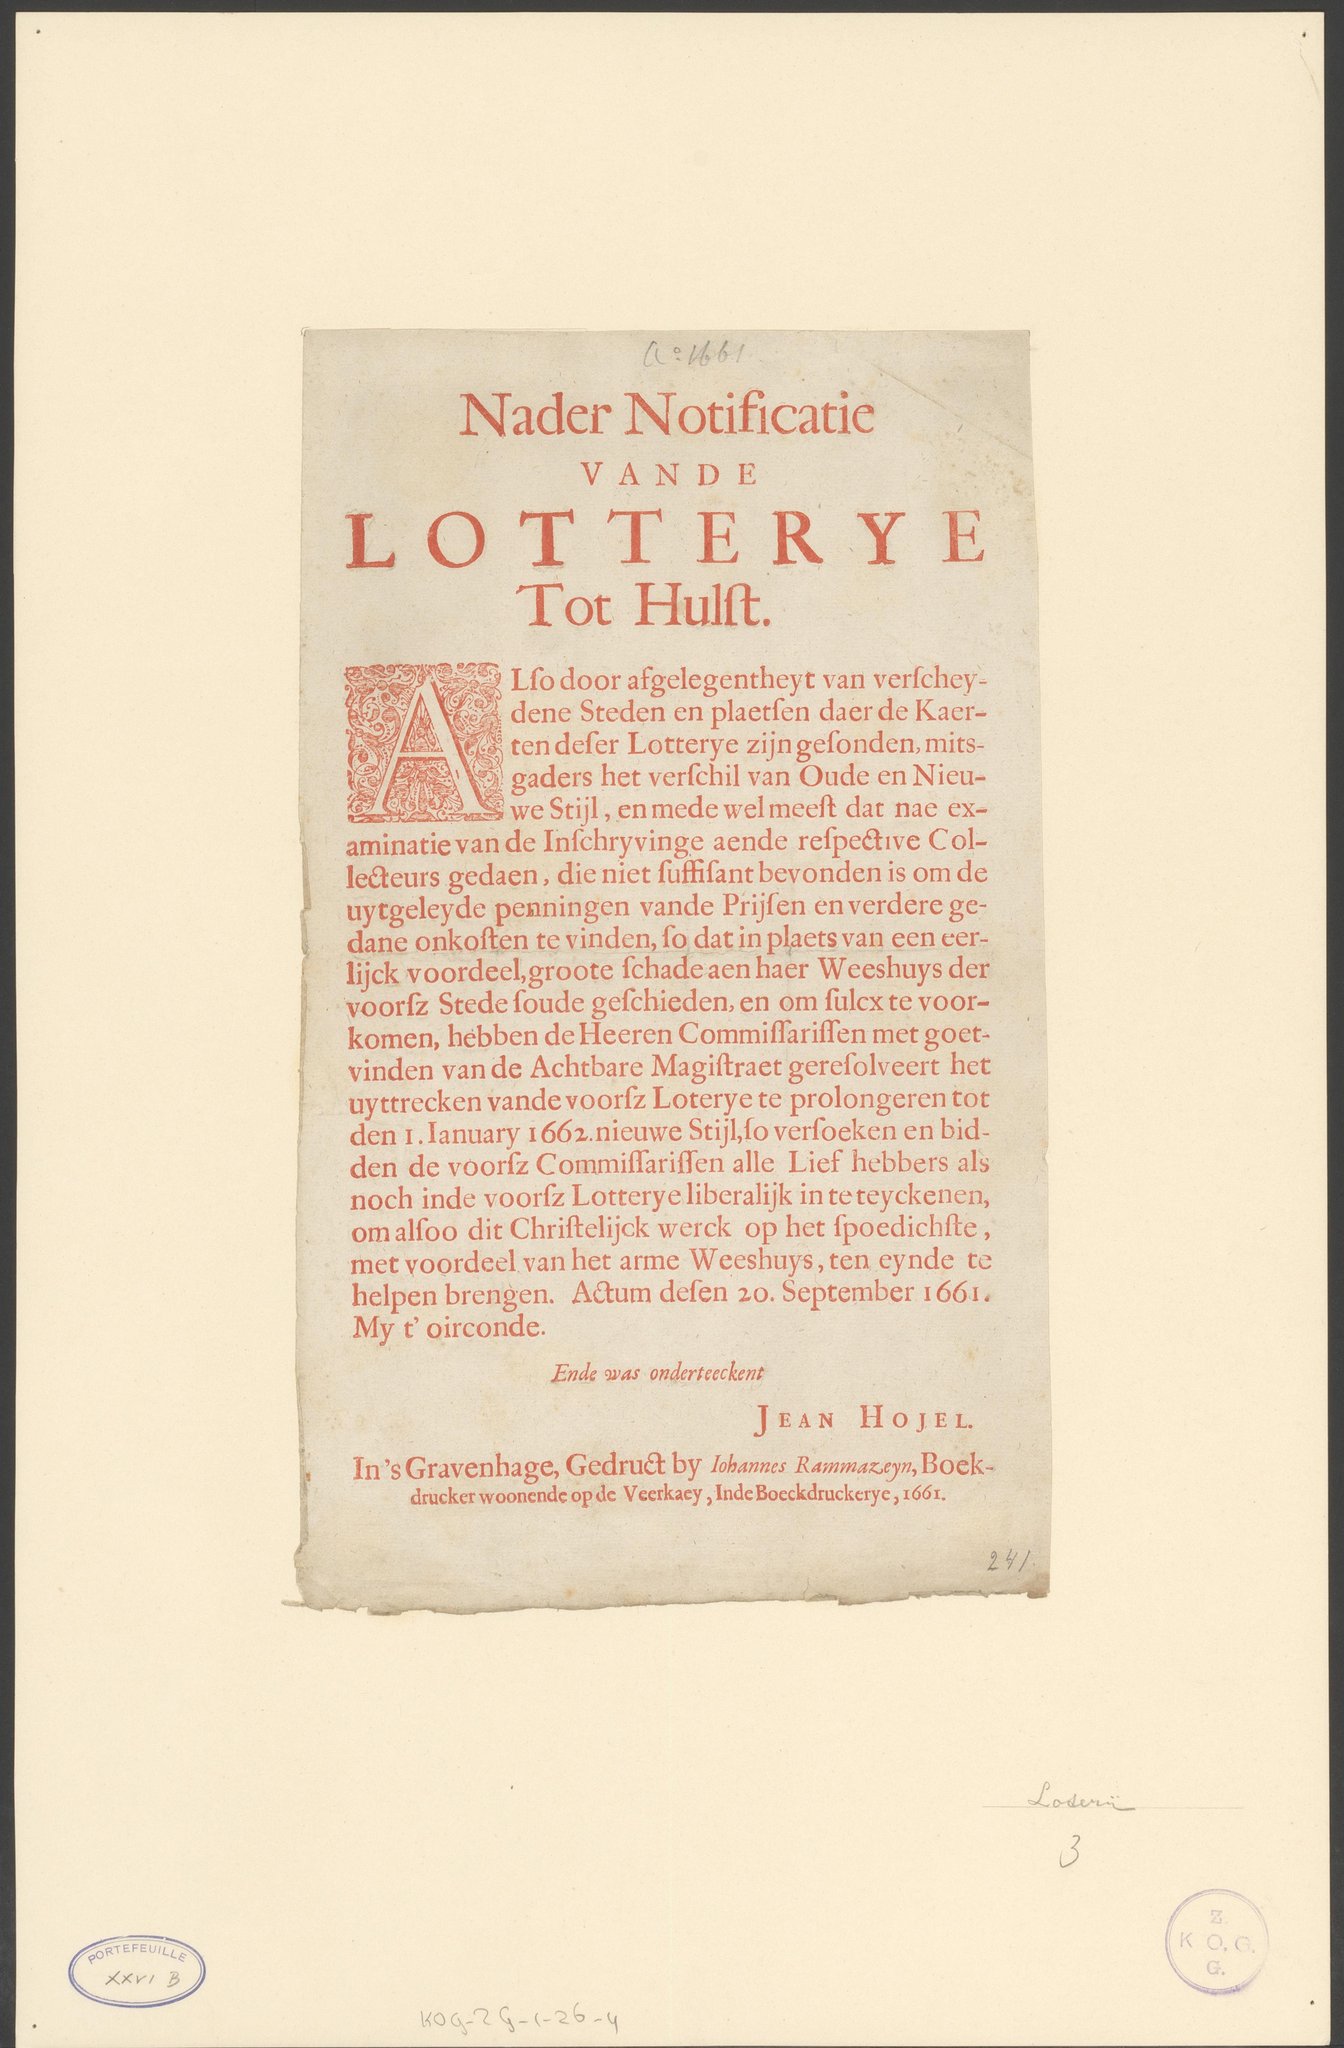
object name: text sheet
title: Nader Notificatie van de Lotterye tot Hulst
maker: johannes rammazeyn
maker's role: printer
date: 1661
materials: paper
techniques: letterpress printing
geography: the hague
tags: raffle, lottery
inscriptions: collector's mark, collector's mark: Lugt 1641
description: Blad met aankondiging van de verlenging van de loterij gehouden te Hulst ten behoeve van het weeshuis tot 1 januari 1662. Onderwerpsrubrieken binnen de Atlas Zeden en Gewoonten: Spel en Vermaak; Loterij.